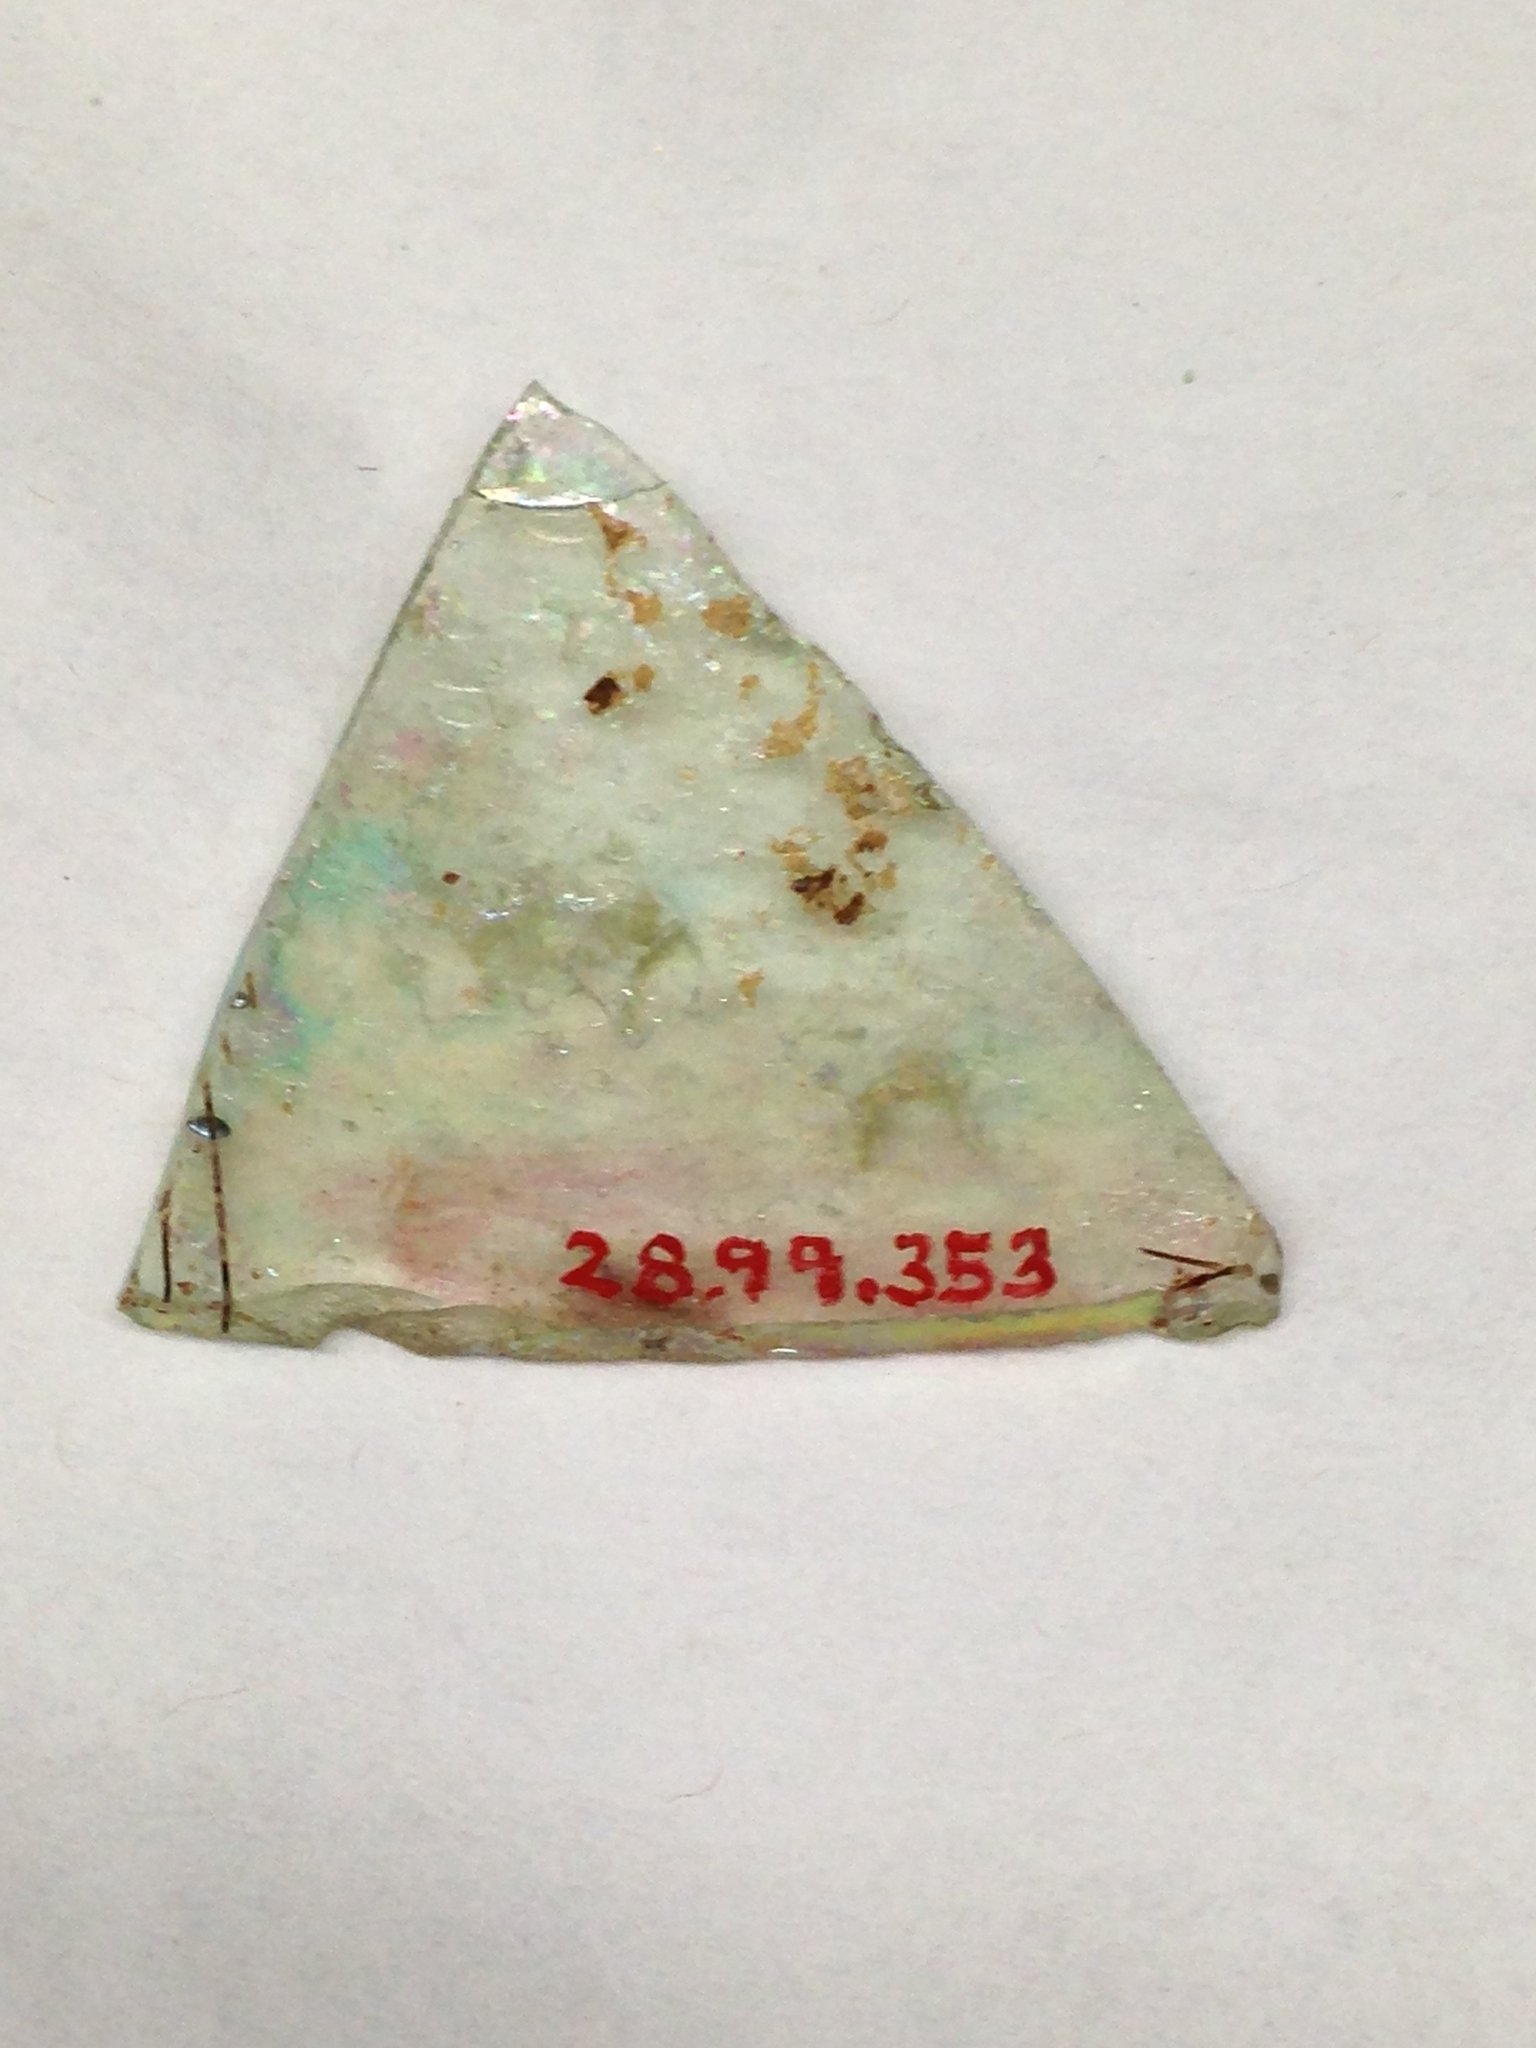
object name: fragment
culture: european or middle eastern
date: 1150-1250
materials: ceramic, glass